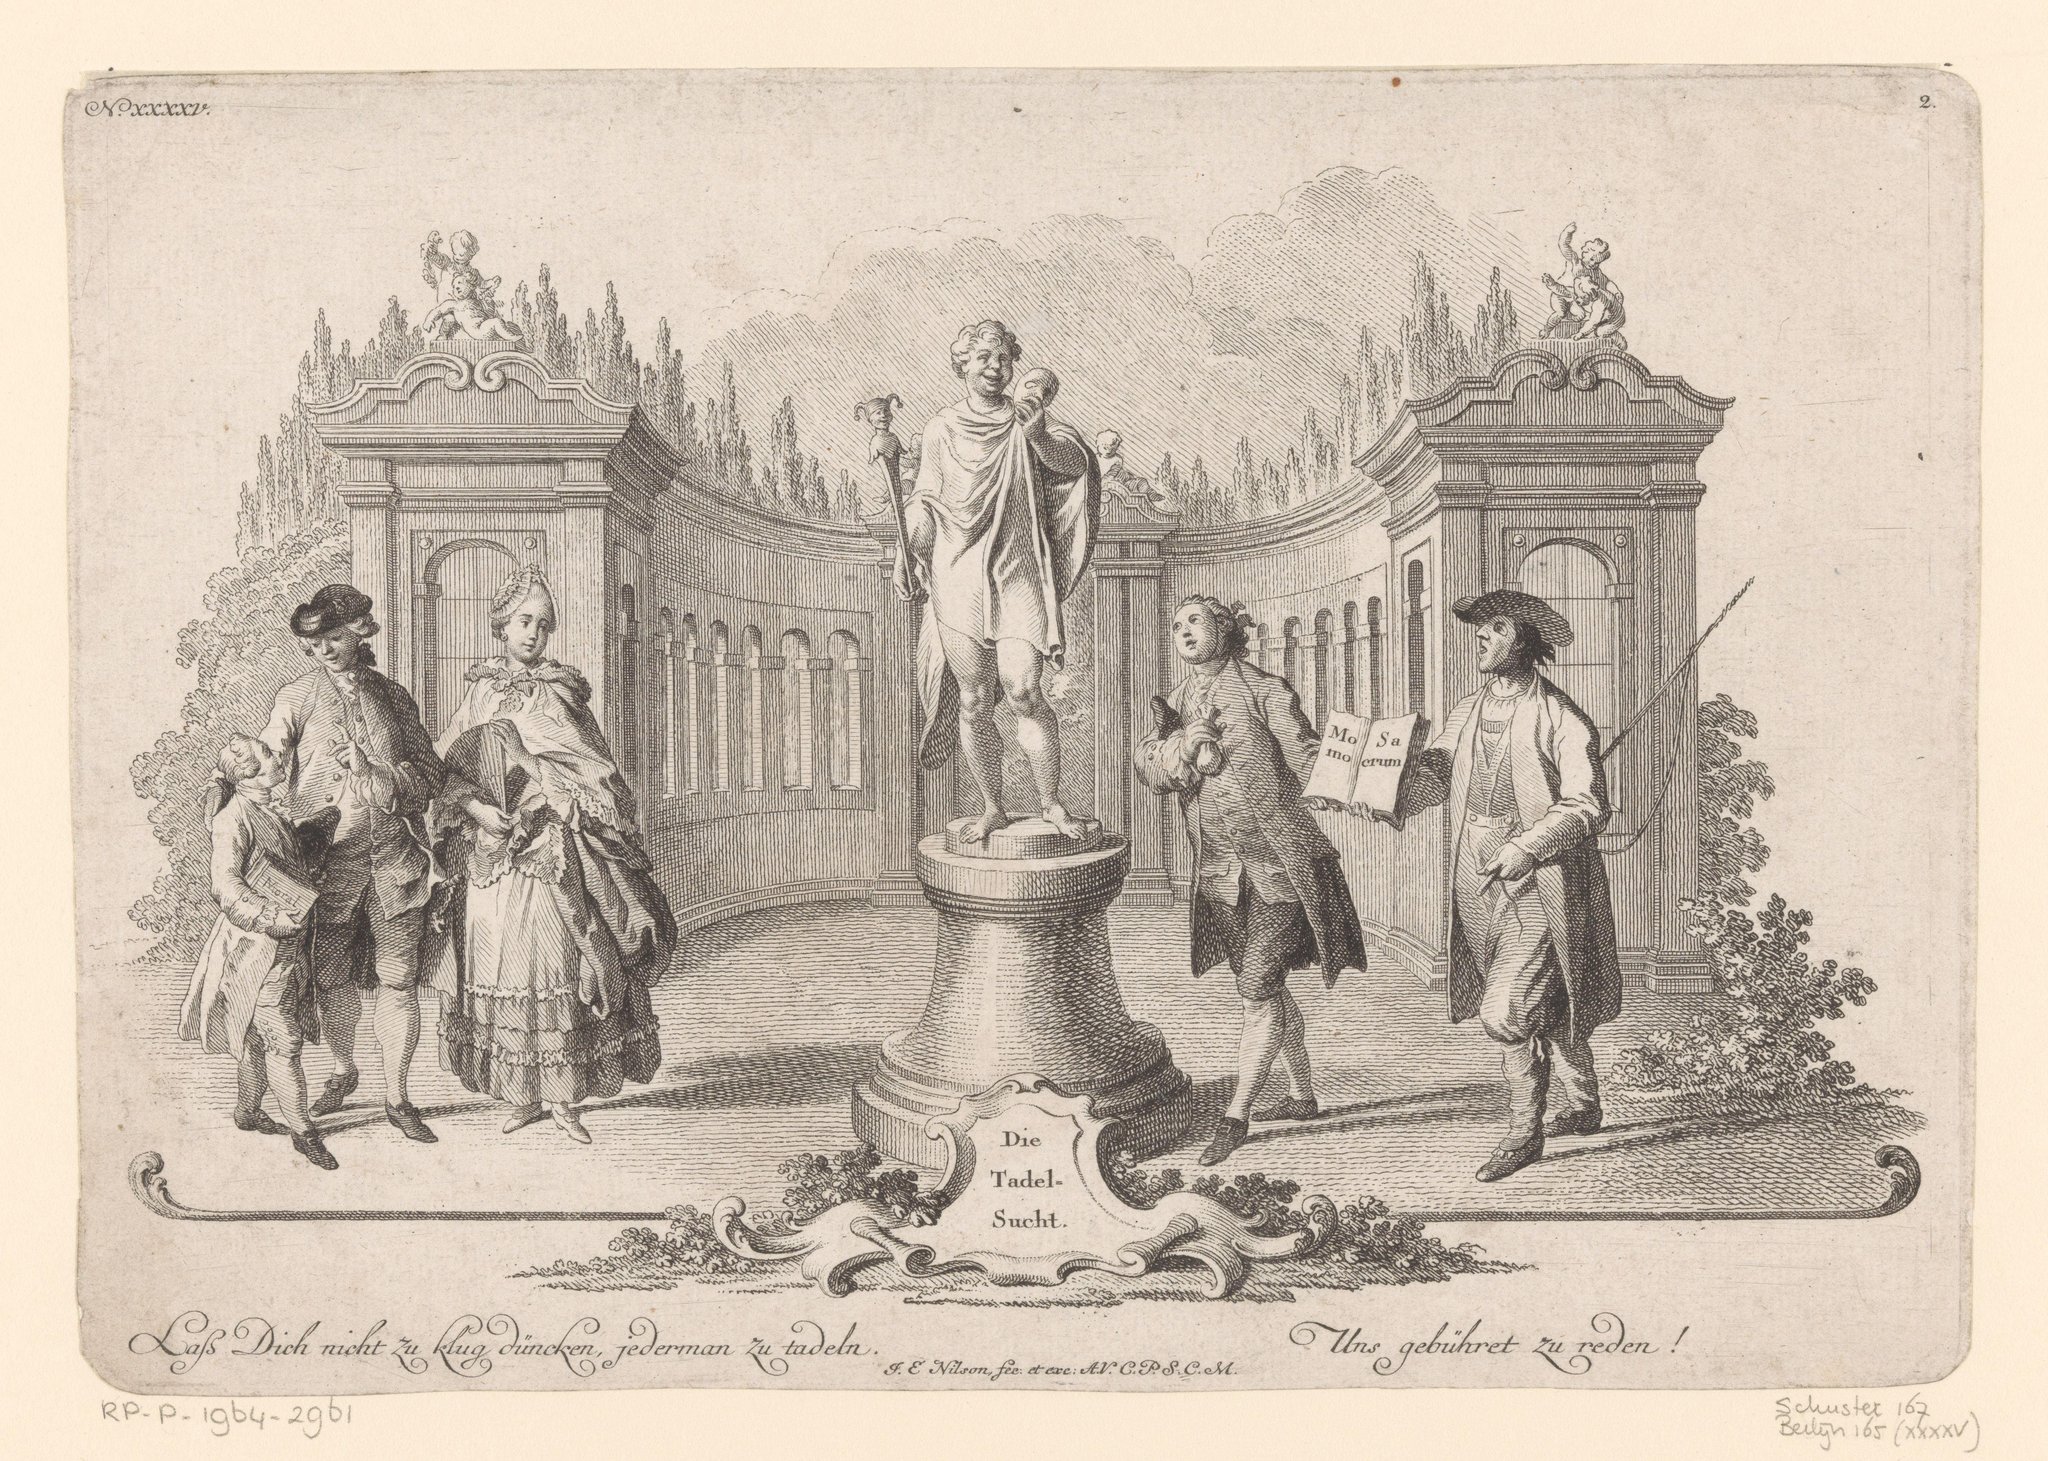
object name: ornament print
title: Polemische scènes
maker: johann esaias nilson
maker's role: draughtsman, print maker, publisher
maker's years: 1721-1788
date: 1771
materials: paper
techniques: etching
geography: augsburg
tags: mask, (story of) momus, disapprobation, disapproval, rebuking, family group, especially parents with their child(ren)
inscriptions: collector's mark: Lugt 2760, collector's mark: Lugt 2228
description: Voor een halfrond gebouw staat een beeld van een nar met staf en masker in zijn hand. Links lopen een man en een vrouw met hun kind, zij geven hem het advies mensen niet te bedillen. Rechts staan twee gemaskerde mannen met een geldbuidel, een zweep en een open boek met de tekst Momo Sacrum. De tekst verwijst naar Momus, personificatie van de kritiek en god van dichters en schrijvers. In de ondermarge een Duitse tekst. Uitgeversnummer XXXXV.